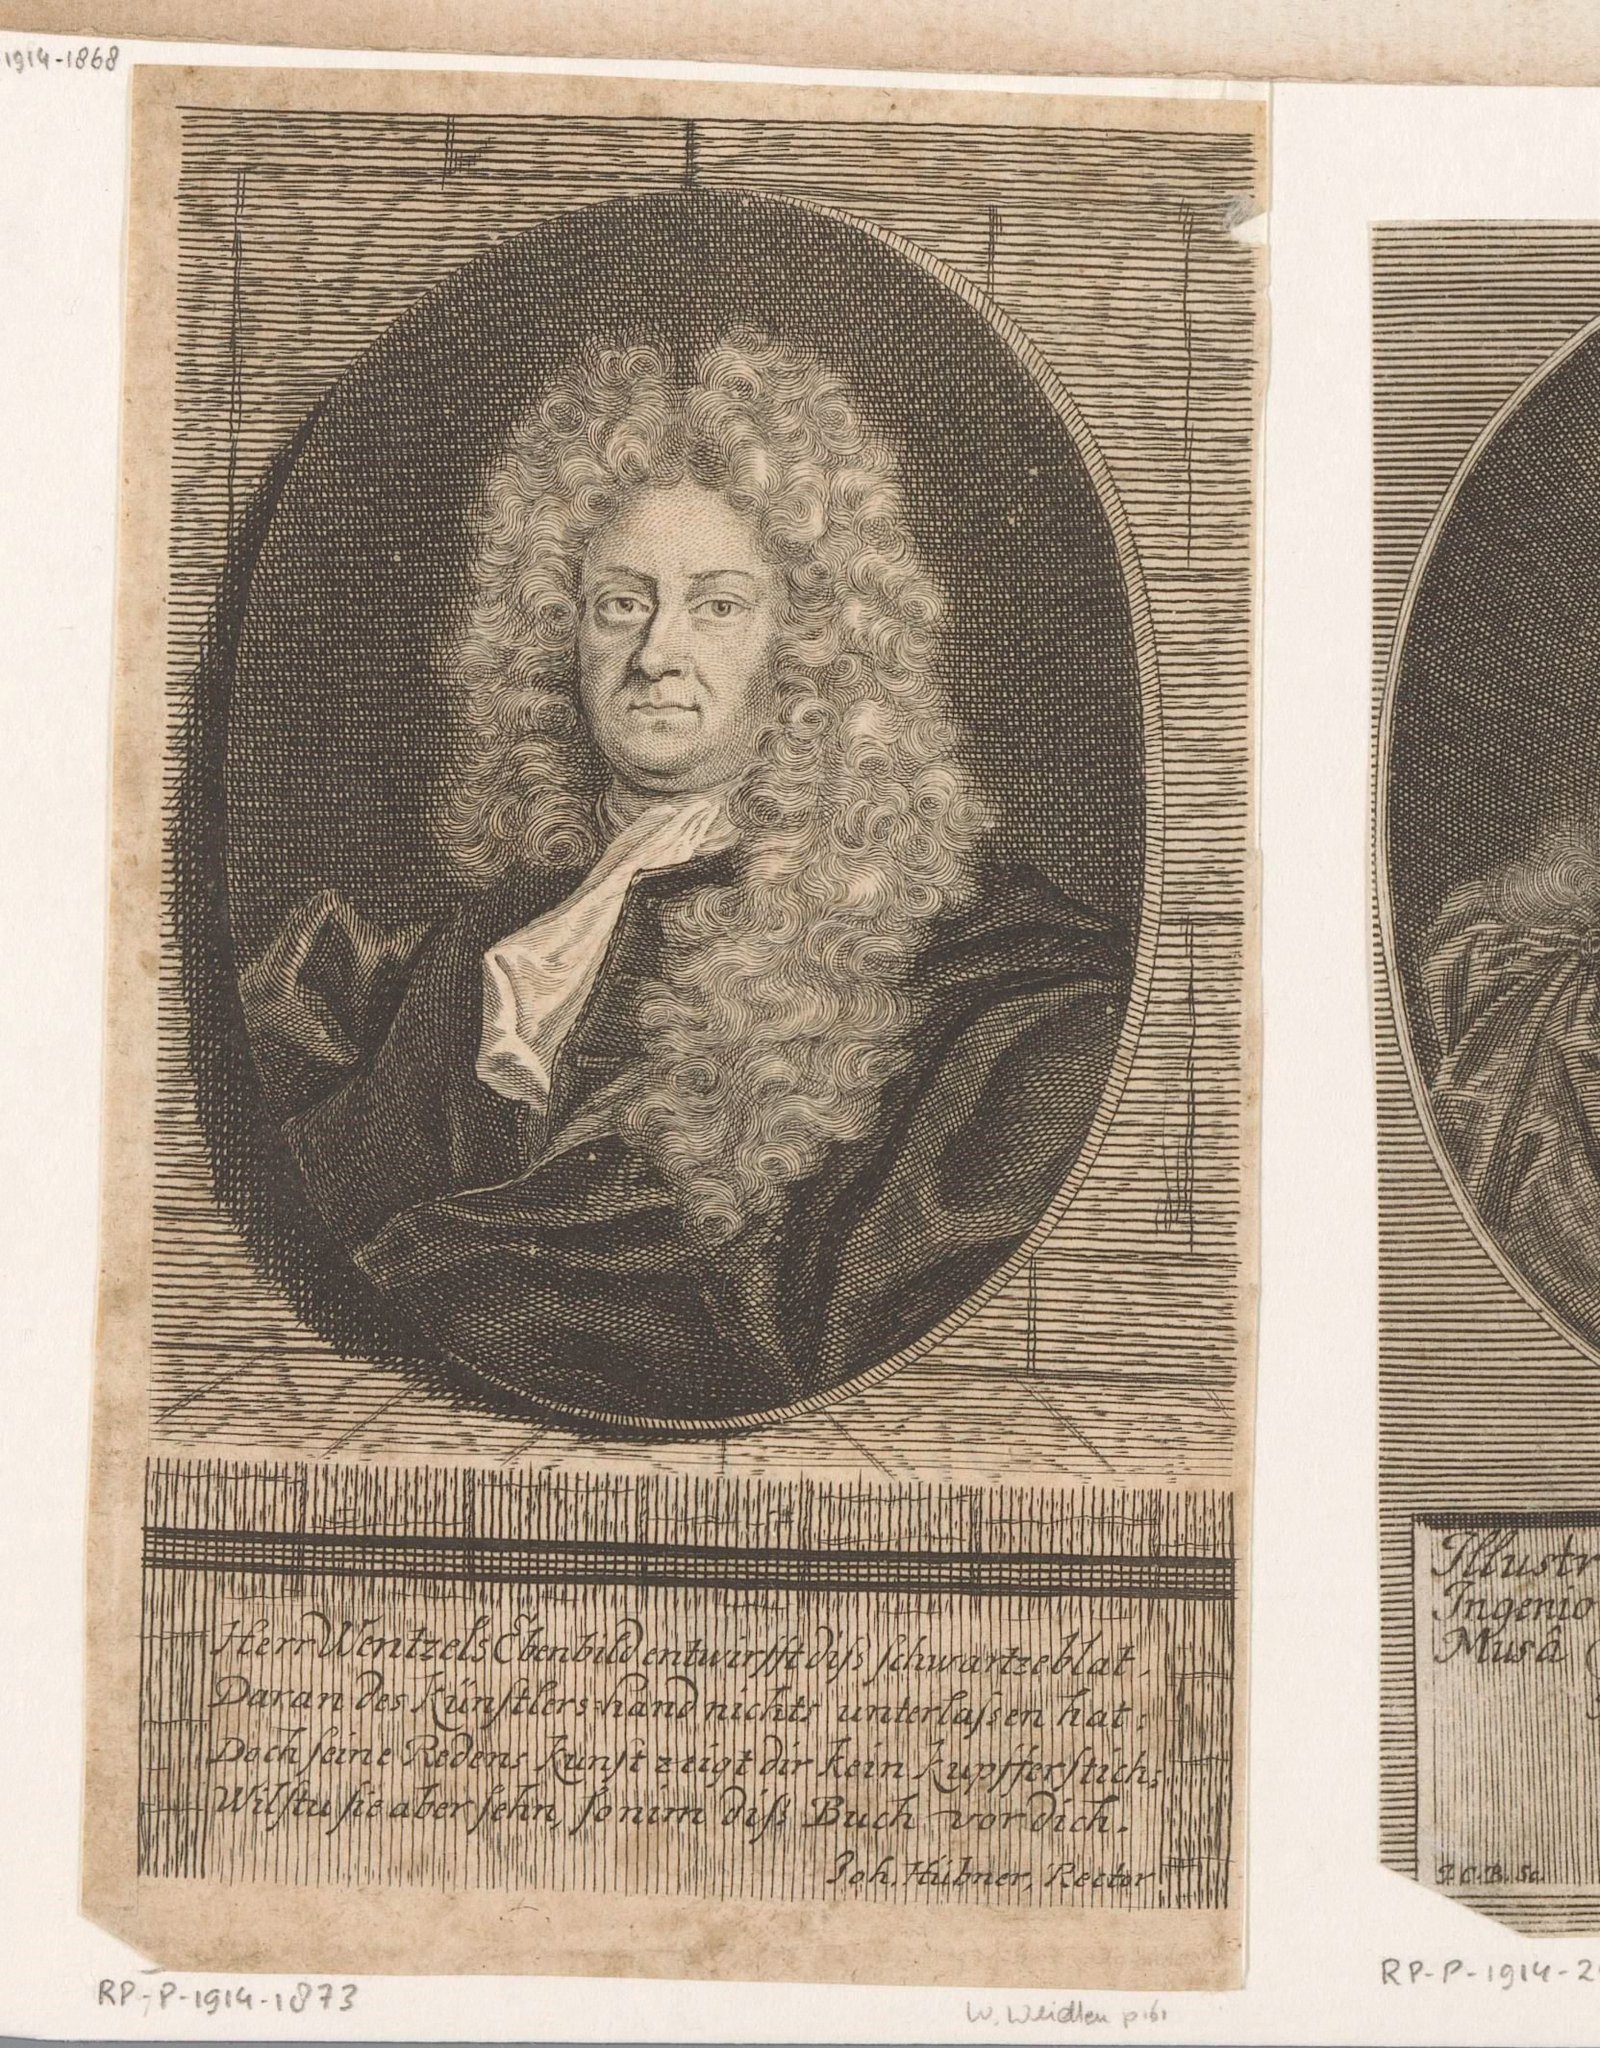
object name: print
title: Portret van Johann Christoph Wentzel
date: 1694-1733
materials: paper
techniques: engraving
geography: leipzig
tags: historical persons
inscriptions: collector's mark: Lugt 2228